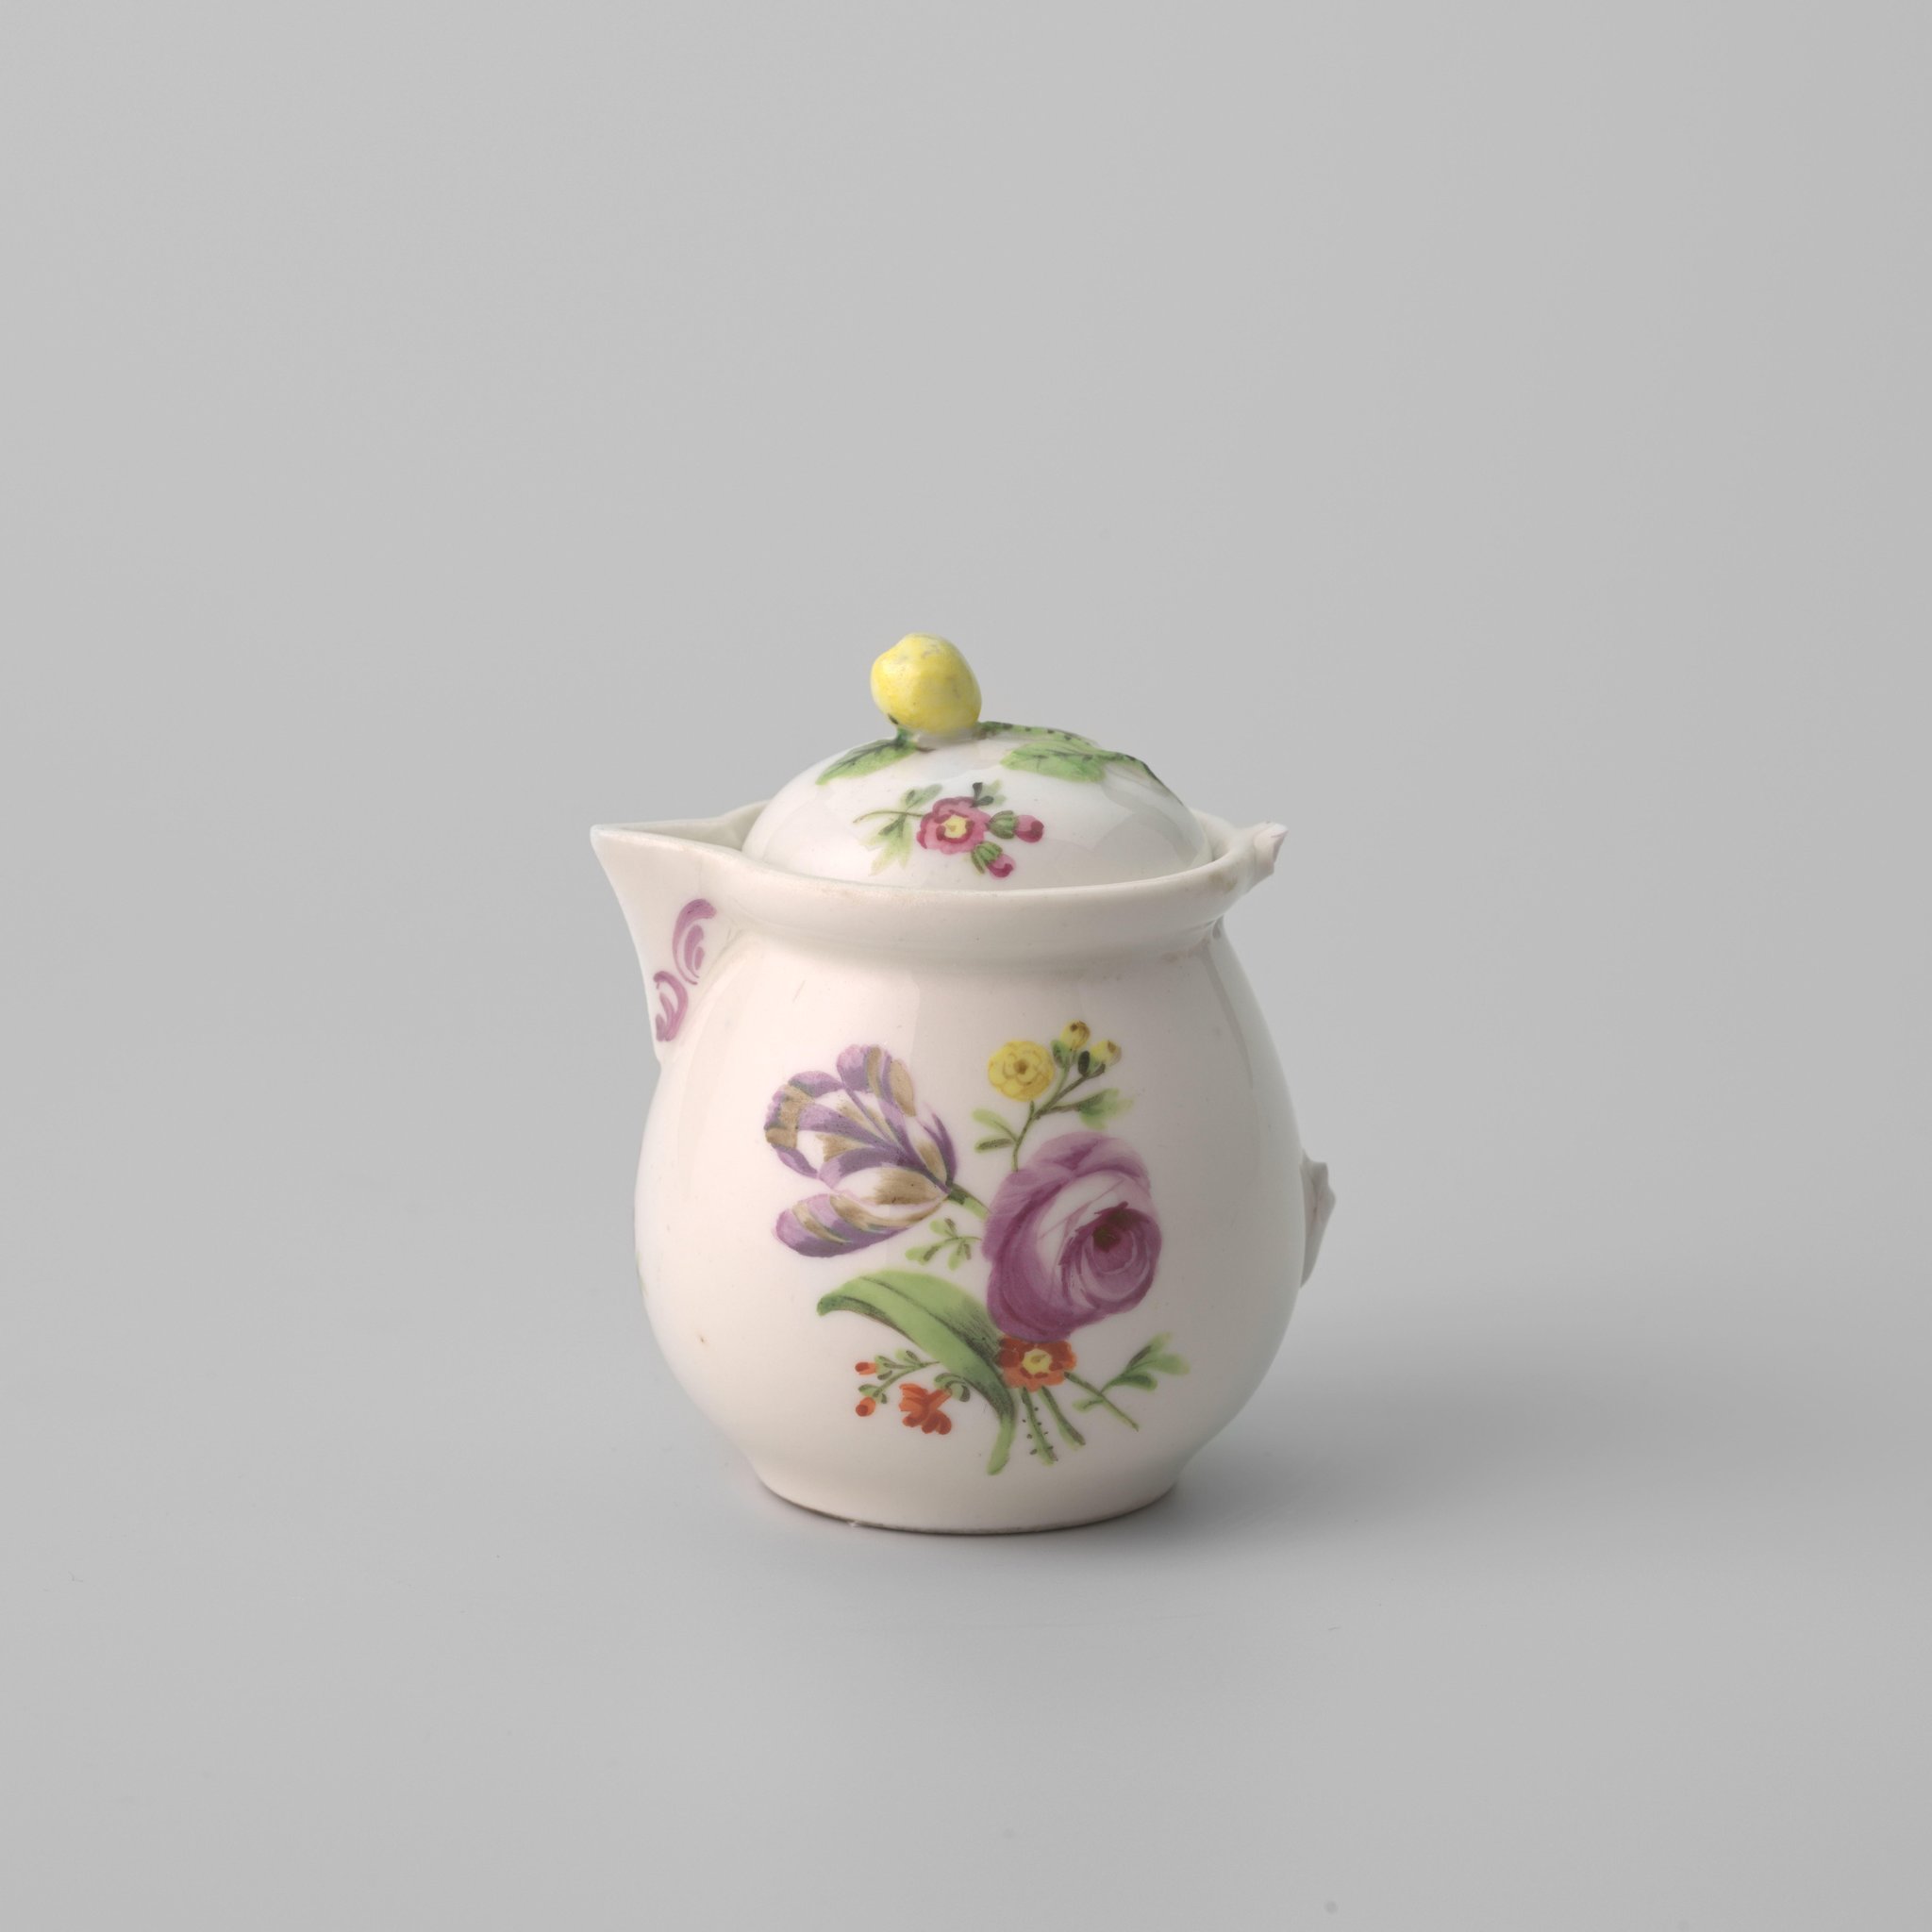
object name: service set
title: Milk jug with a bouquet and flower sprays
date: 1800-1849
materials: glaze, paint, porcelain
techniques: firing, forming, turning, vitrification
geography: vienna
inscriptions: mark: ‘schild/ N/ 90./ 4 / 87’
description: Melkkan van porselein met een bolvormige buik en korte tuit vanuit de nek en rand, beschilderd op het glazuur in rood, roze, groen, geel en paars. Op de buik tweemaal een boeket van verschillende bloemen (o.a. pioenroos) omgeven door losse takjes. De tuit en het (afgebroken) oor met ranken en bloemen. De deksel met bloemtakken en de dekselknop in de vorm van een fruittak (peer). Gemerkt op de onderzijde met het schild, letter N en de nummers 90., 4 en 87.